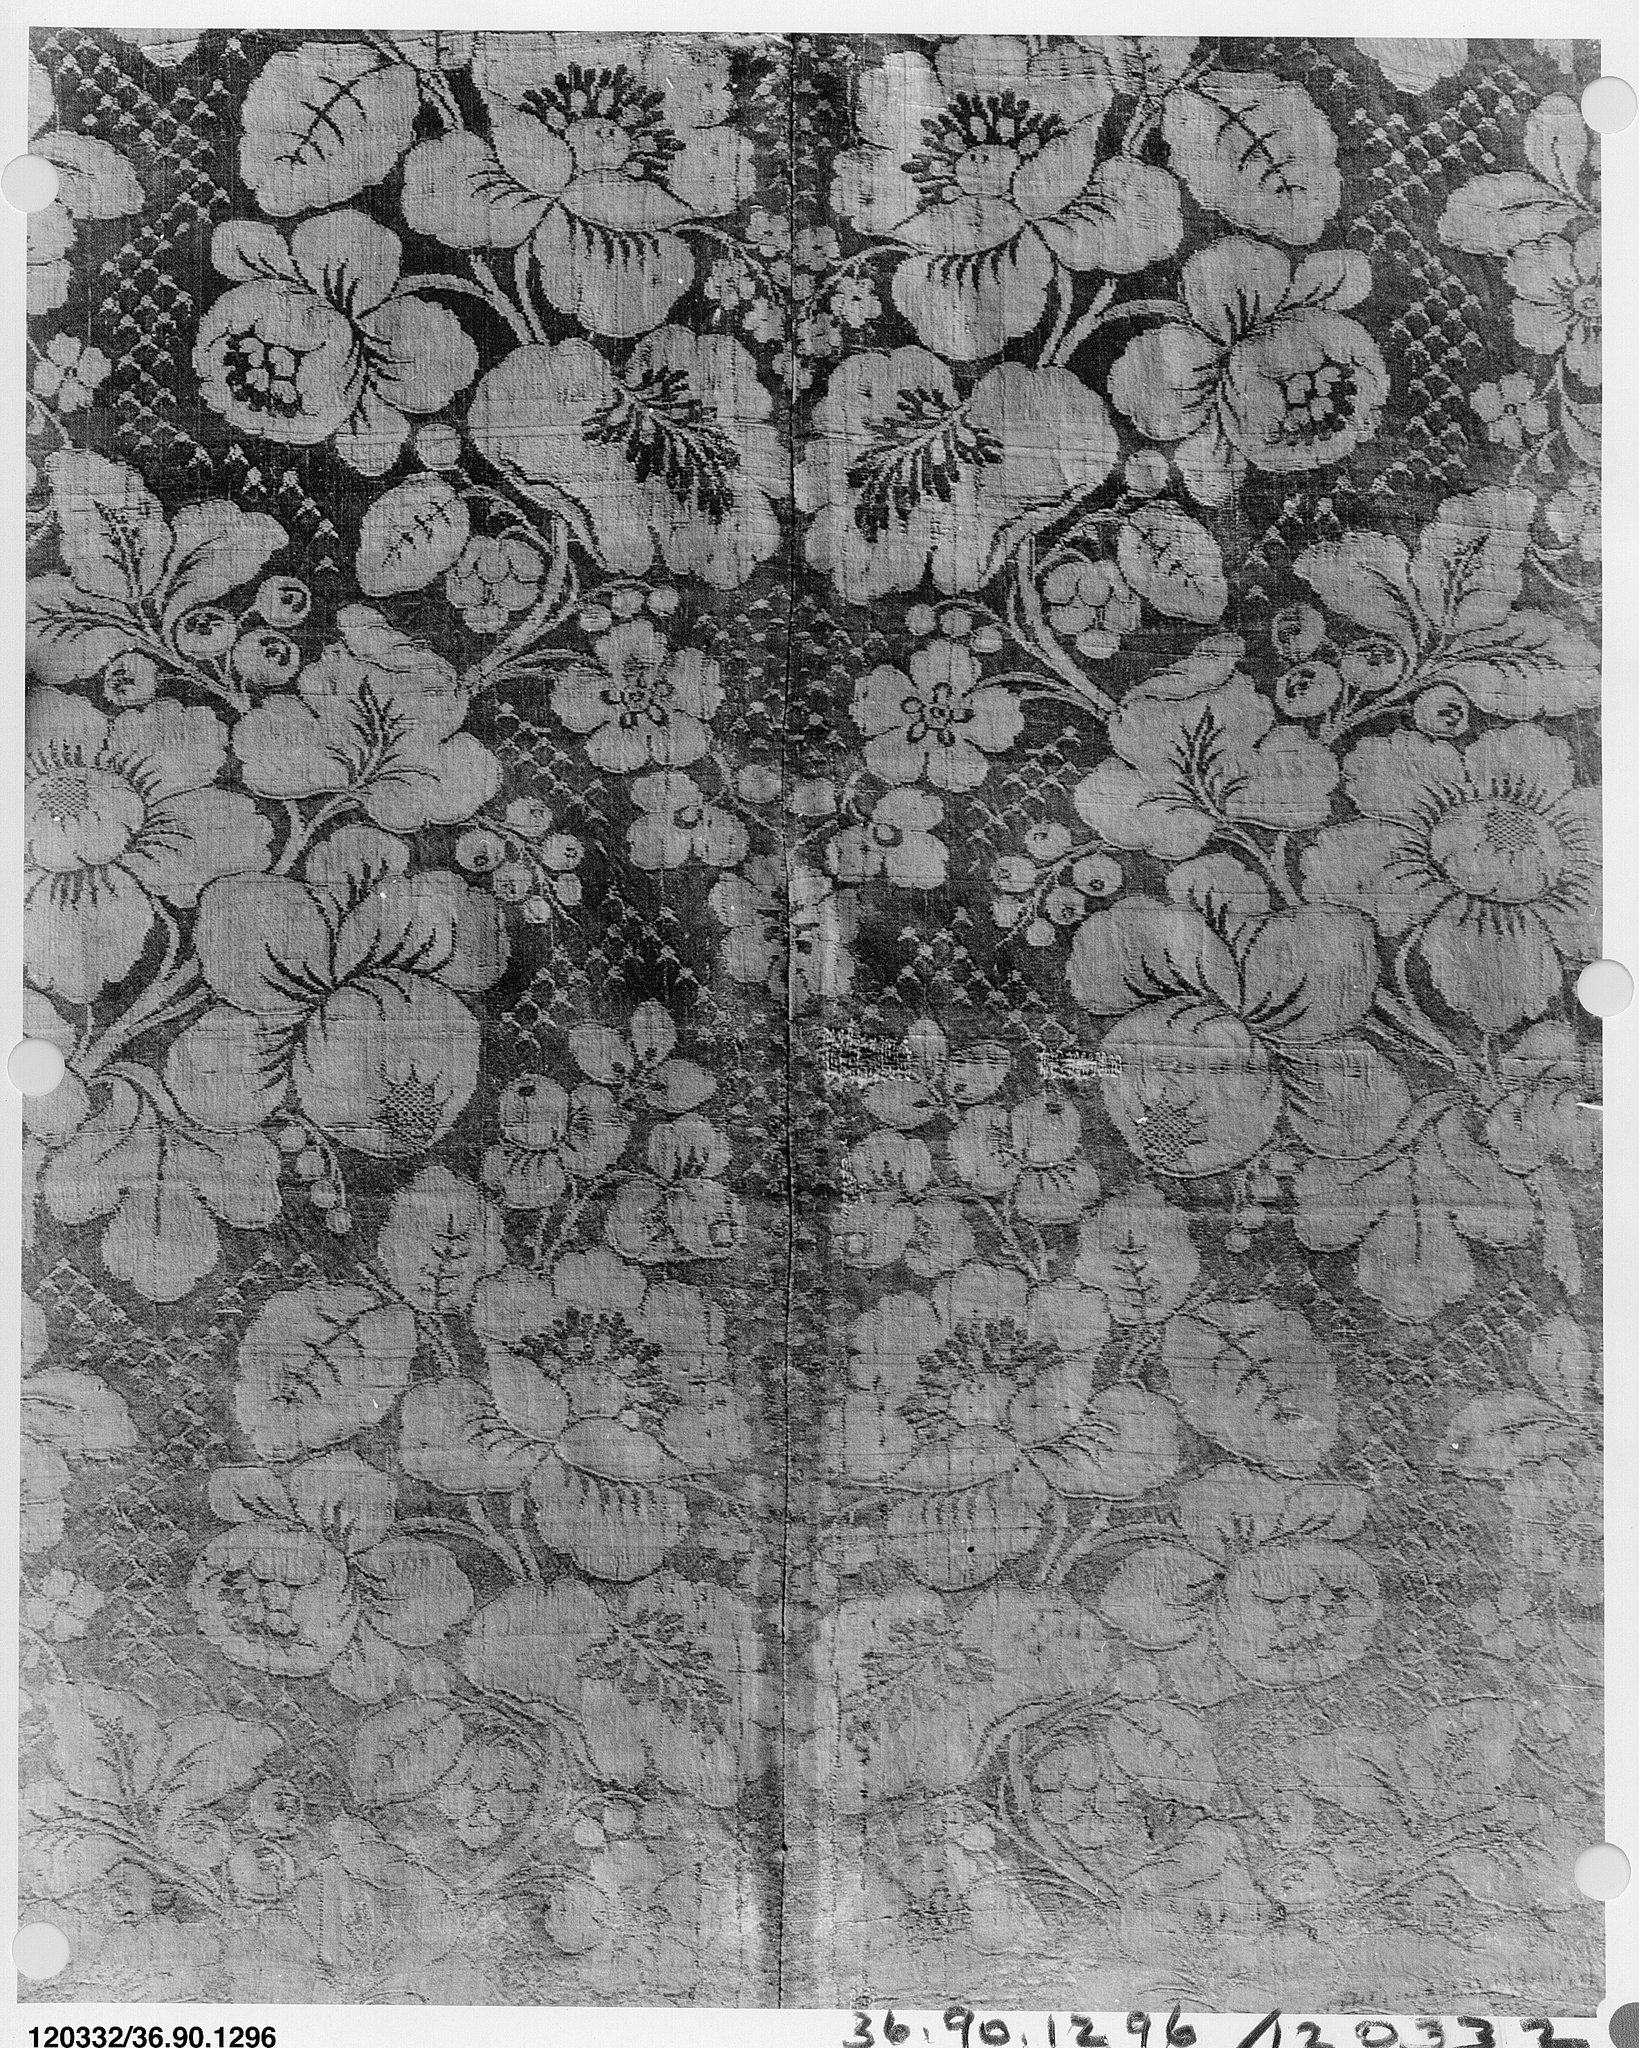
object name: piece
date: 1750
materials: silk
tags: flowers,leaves